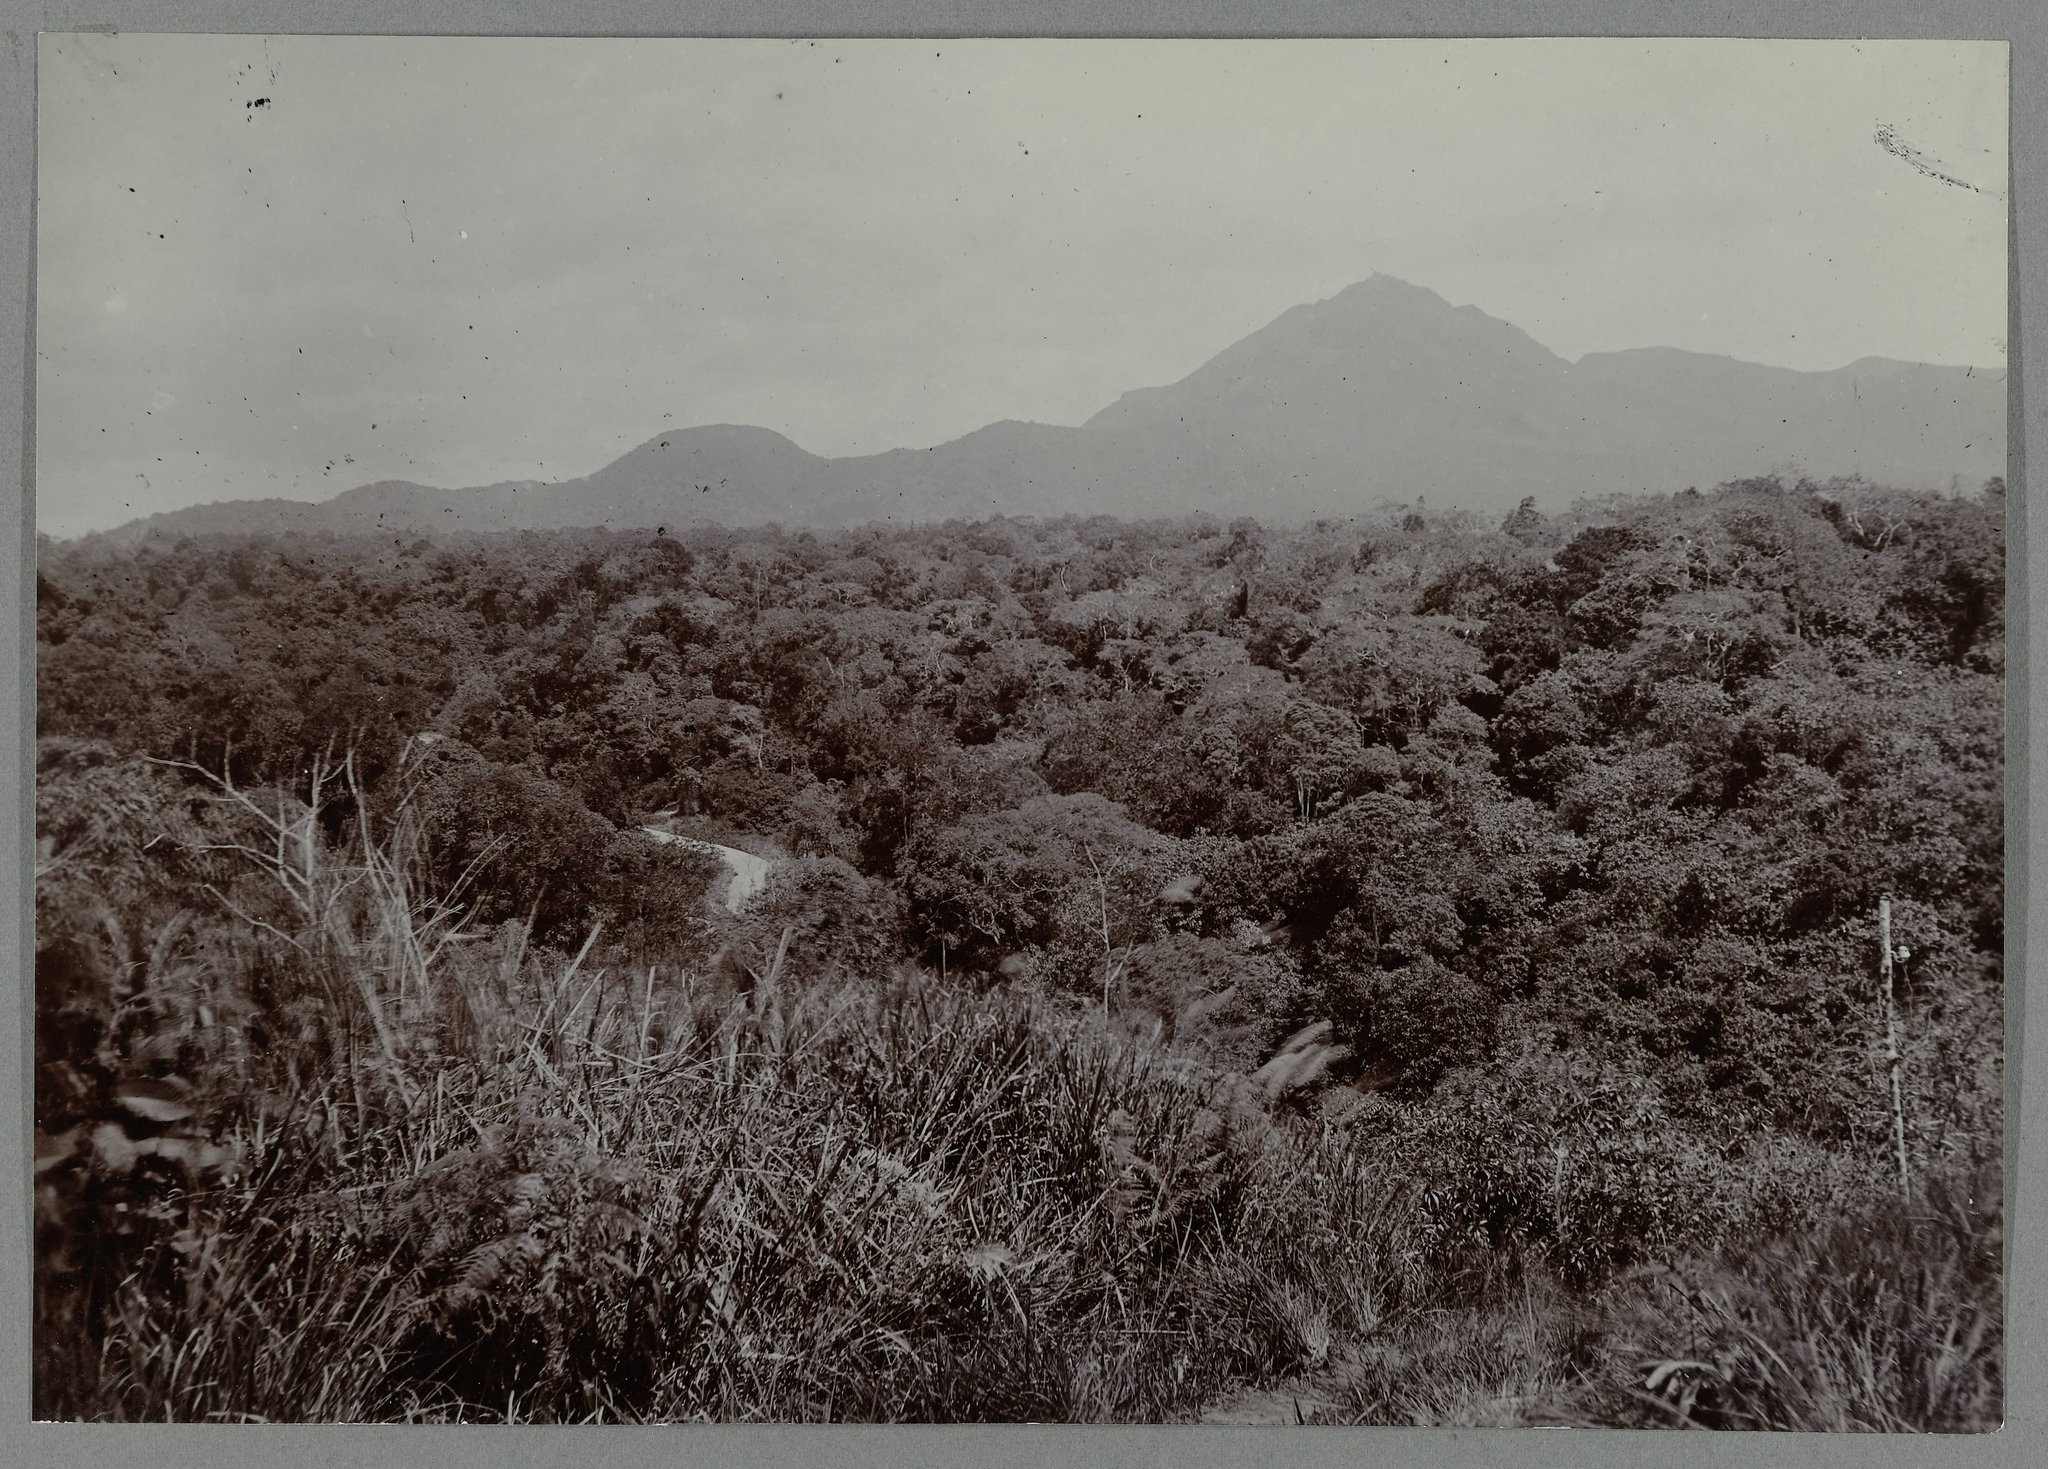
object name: photograph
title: Boslandschap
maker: Anonymous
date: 1903-1913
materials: photographic support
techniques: photography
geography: north sumatra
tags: arnhem, the hague, albertus dominicus laman trip, road, path, jungle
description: Na de expedities naar de Gajo- en Alaslanden o.l.v. Van Daalen (eerste tocht in 1901), werd hij in 1903 belast met voorbereiding van permanente vestiging van Nederlands gezag. Aanleg van een weg van de Noordkust naar het binnenland was hierbij van groot belang. Deze zgn. Gajoweg werd aangelegd tussen 1903 en 1914, van Bireuen aan de kust naar Takinguen aan het bergmeer Danau Lauttawar, totale lente 104 km.